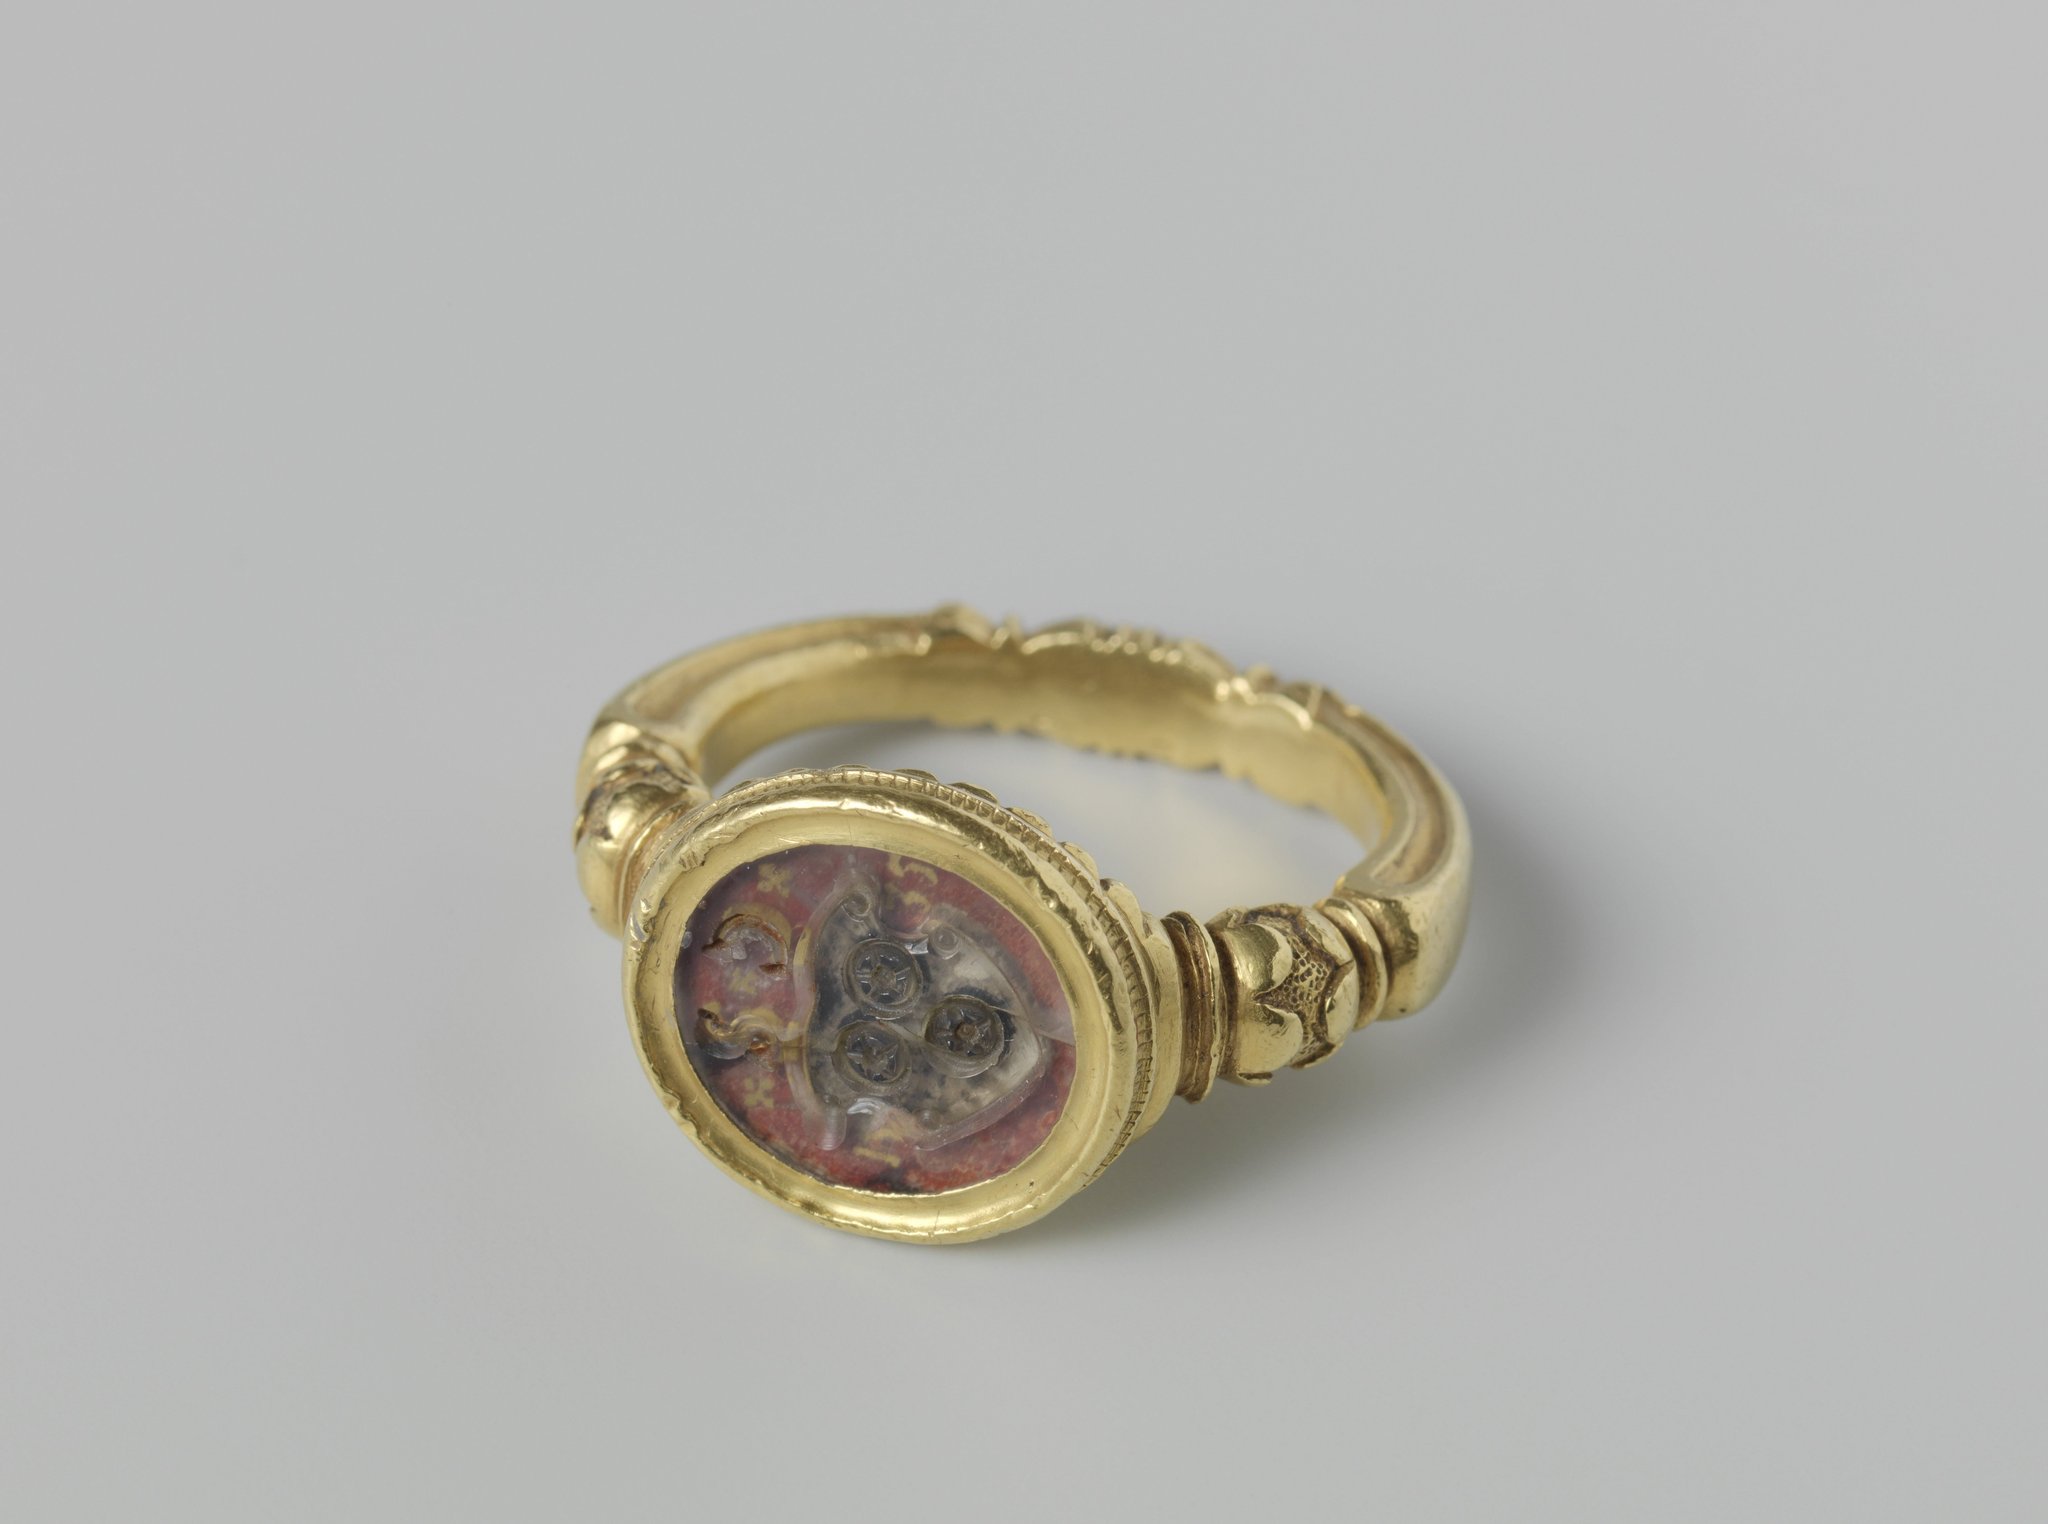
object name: ring, signet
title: Signet ring with the Van Wijnbergen family arms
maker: Anonymous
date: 1535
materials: gold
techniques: painted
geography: northern netherlands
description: In the 16th century, seals were sometimes made of rock crystal. The transparency of this stone made it possible to include a coat of arms both in relief and in colour (on the back of the stone). The one here – three black wheels with five spokes in a field of silver – belongs to the Van Wijnbergens, a noble family from the province of Overijssel. Accordingly, this ring was most likely made in the northern Netherlands.